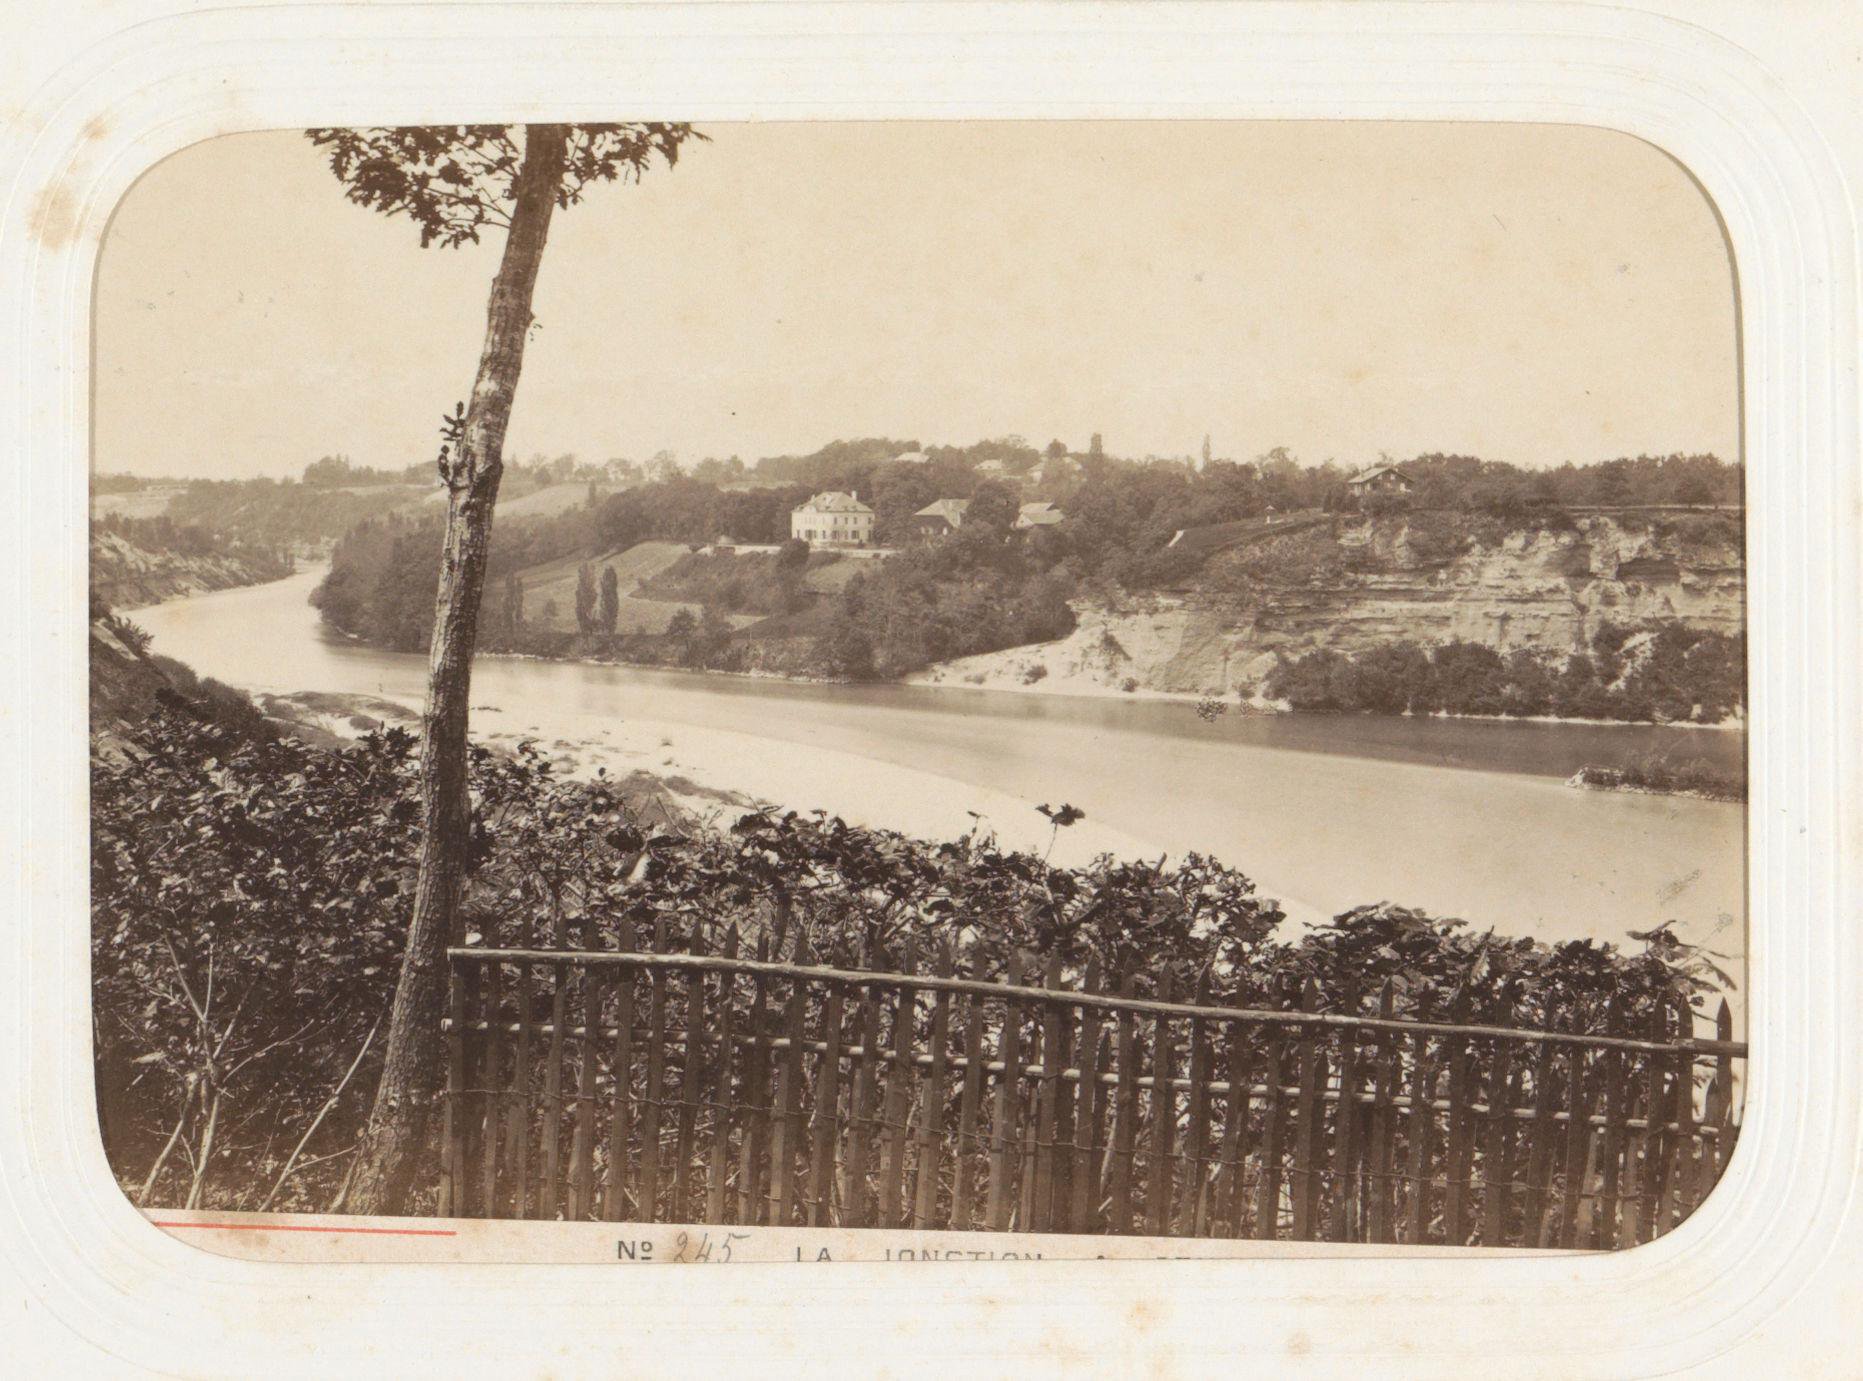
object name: photograph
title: La jonction a Geneve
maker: auguste garcin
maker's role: fotograaf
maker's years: 1816-1895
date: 1860-1880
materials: cardboard, paper, photographic support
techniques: albumen print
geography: geneva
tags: prospect of village, silhouette of village, river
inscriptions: number: ‘245’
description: Onderdeel van Reisalbum met bezienswaardigheden in de Zwitserse Alpen.